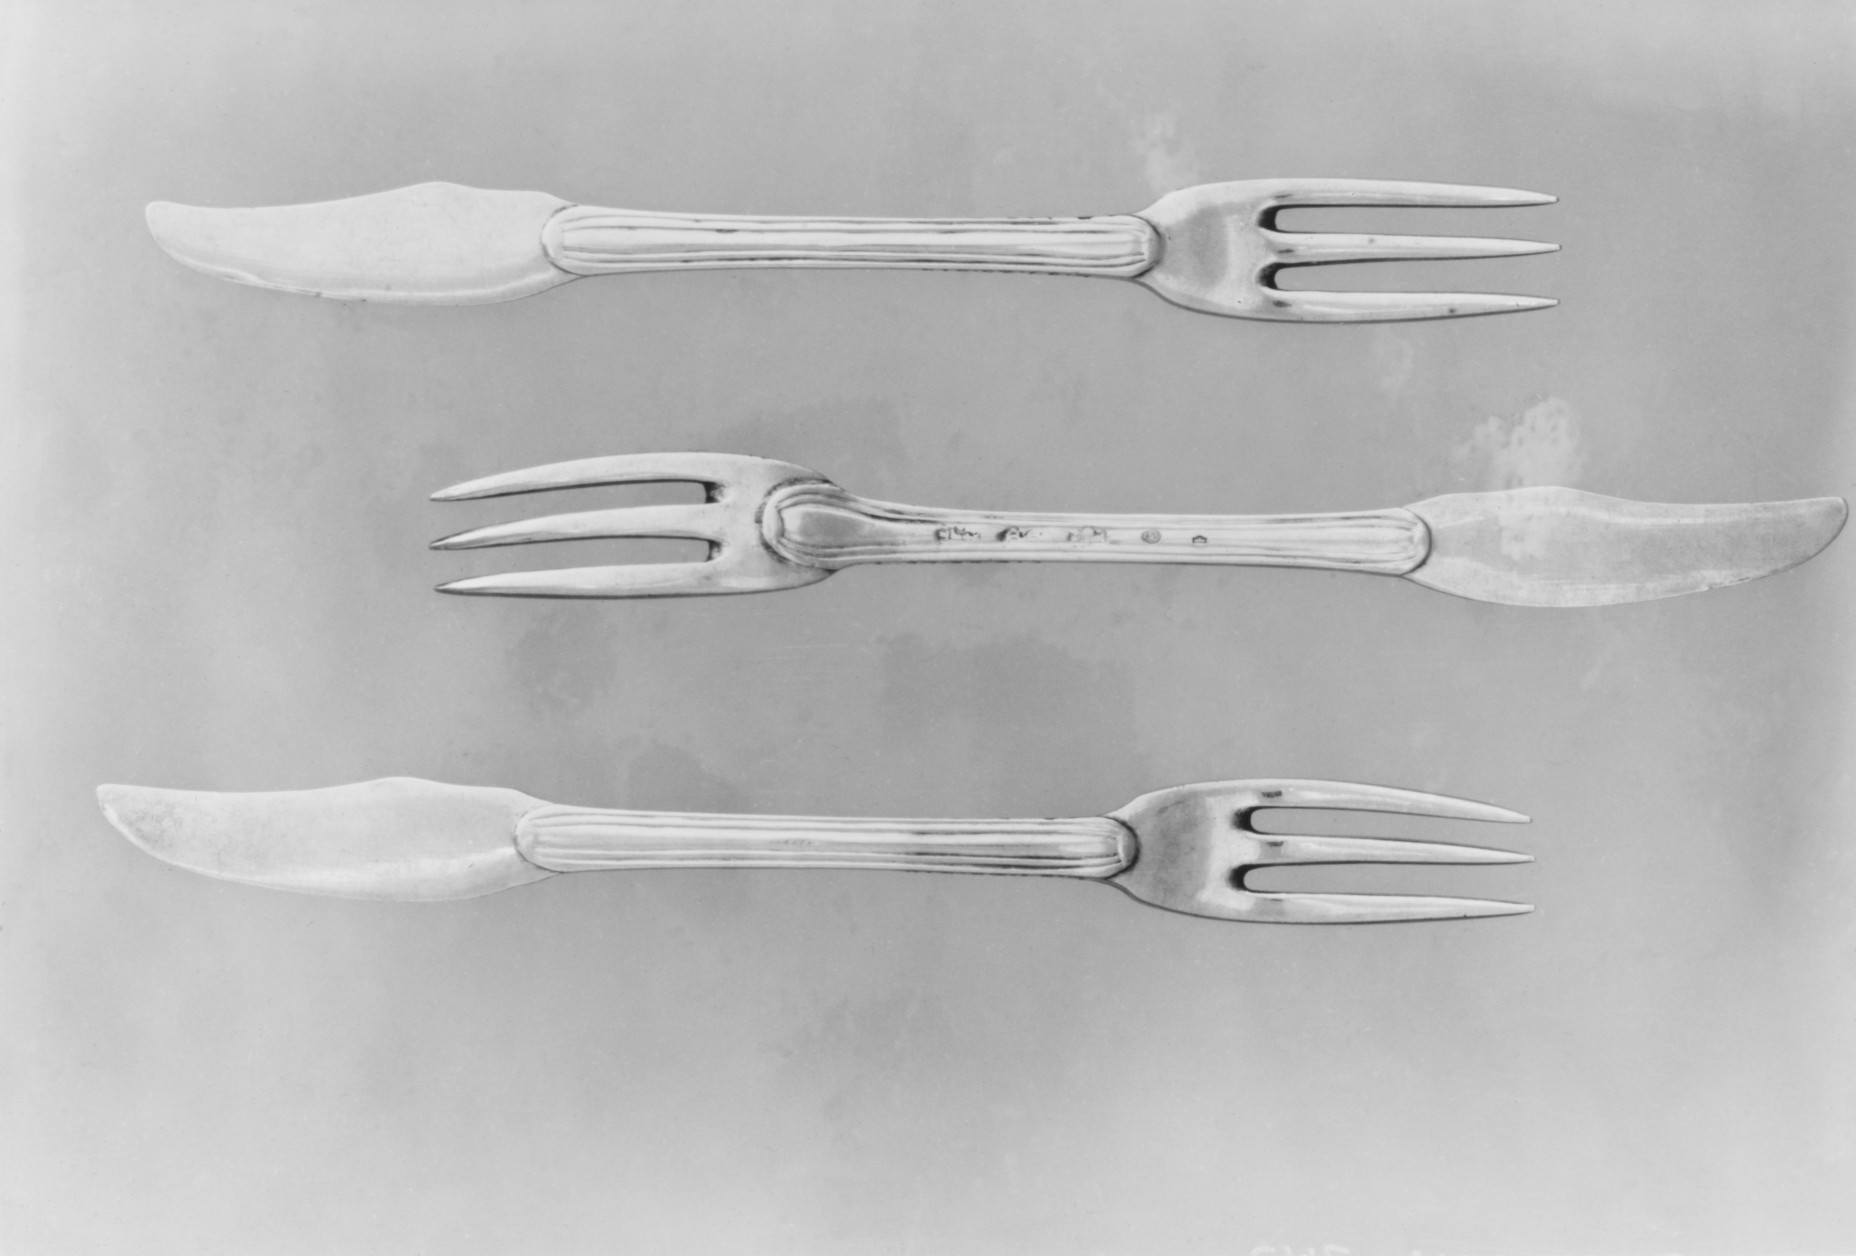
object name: fork with knife handle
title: Fork with knife handle (one of six)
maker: louis-antoine taillepied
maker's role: maker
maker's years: 1734-1834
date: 1778-1779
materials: silver